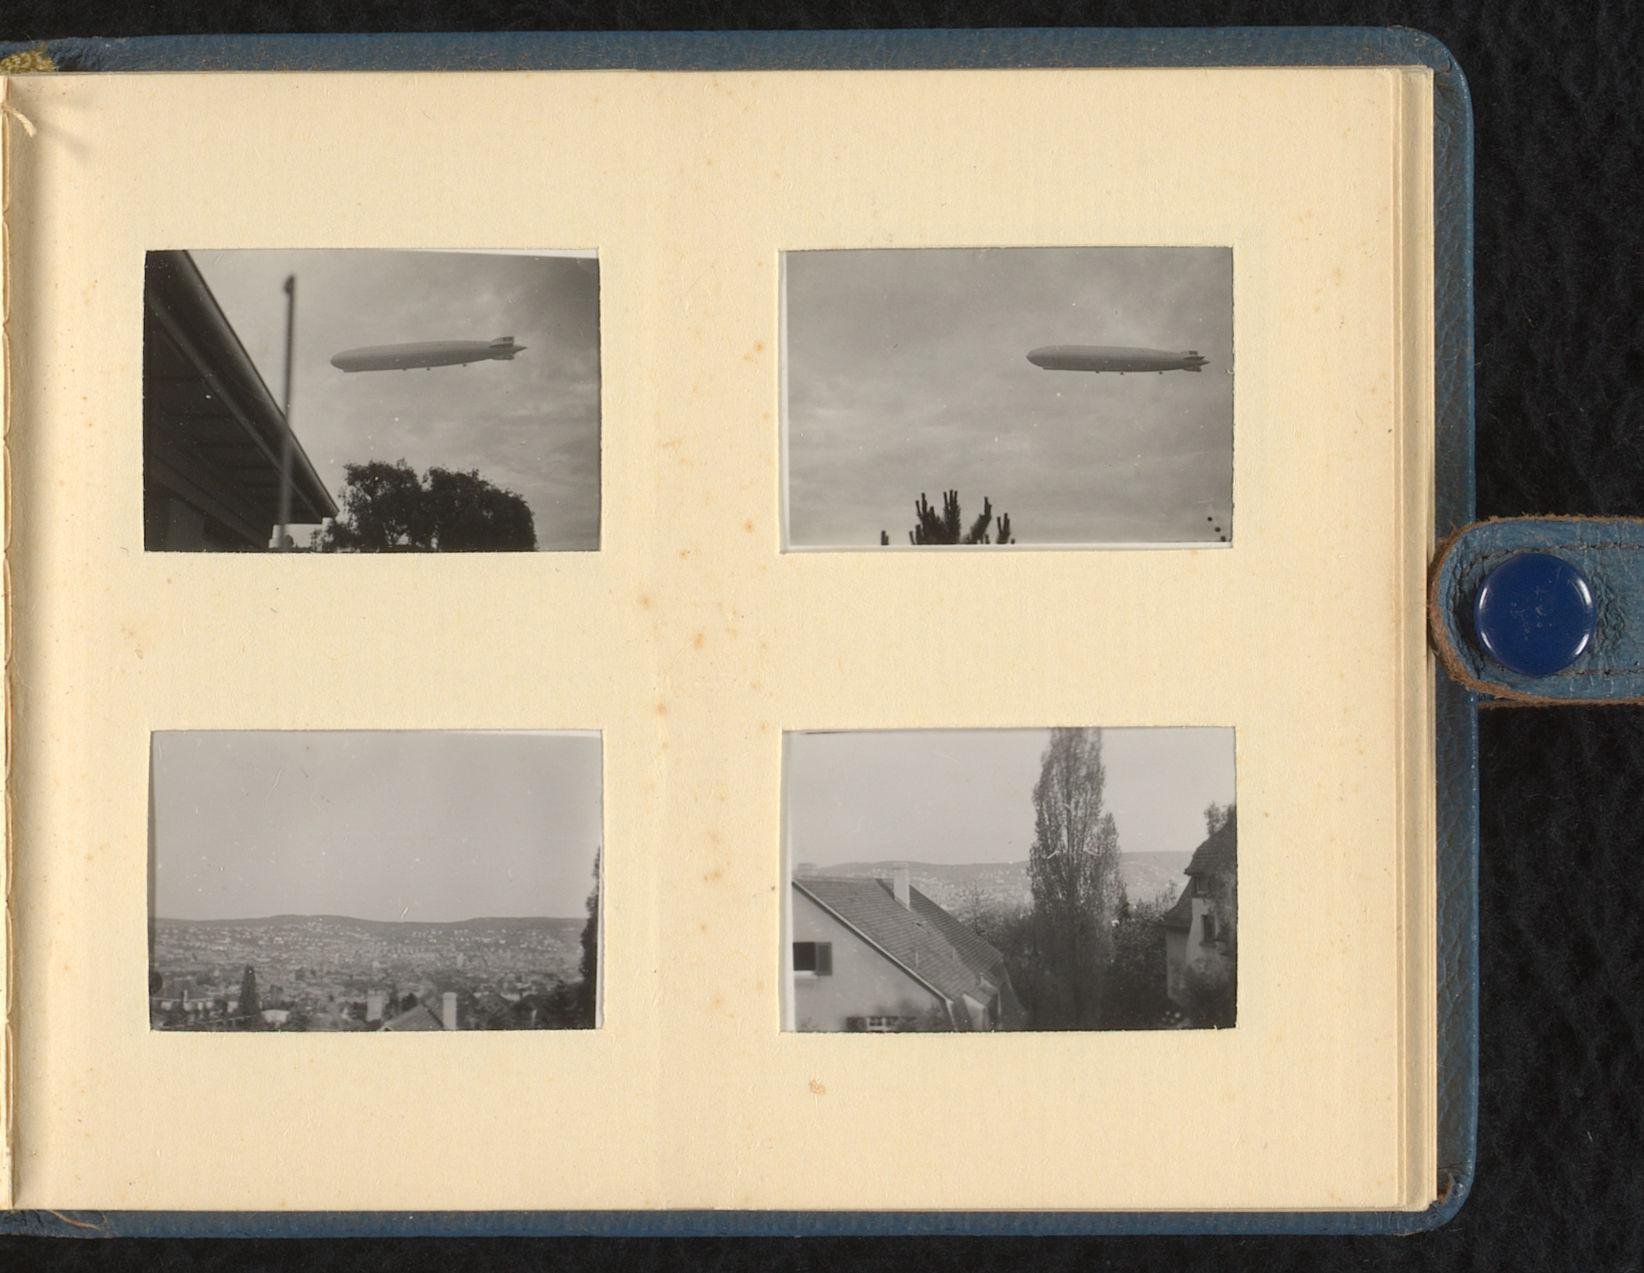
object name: photograph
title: Zeppelin de Hindenburg vliegt over Stuttgart, genomen vanuit der woning van de familie Wachenheimer aan de Hauptmannsreute, mei 1936, Stuttgart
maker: else wachenheimer-moos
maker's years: 1895-1944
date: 1905-1936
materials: paper, photographic support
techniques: gelatin silver print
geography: stuttgart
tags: 46c35 airship, zeppelin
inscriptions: date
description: Albumblad bevat vier foto's. Zonder personen gerelateerd aan de familie Wachenheimer. Uit klein formaat fotoalbum, blauw lederen omslag met drukknopsluiting. Met foto's in klein formaat.